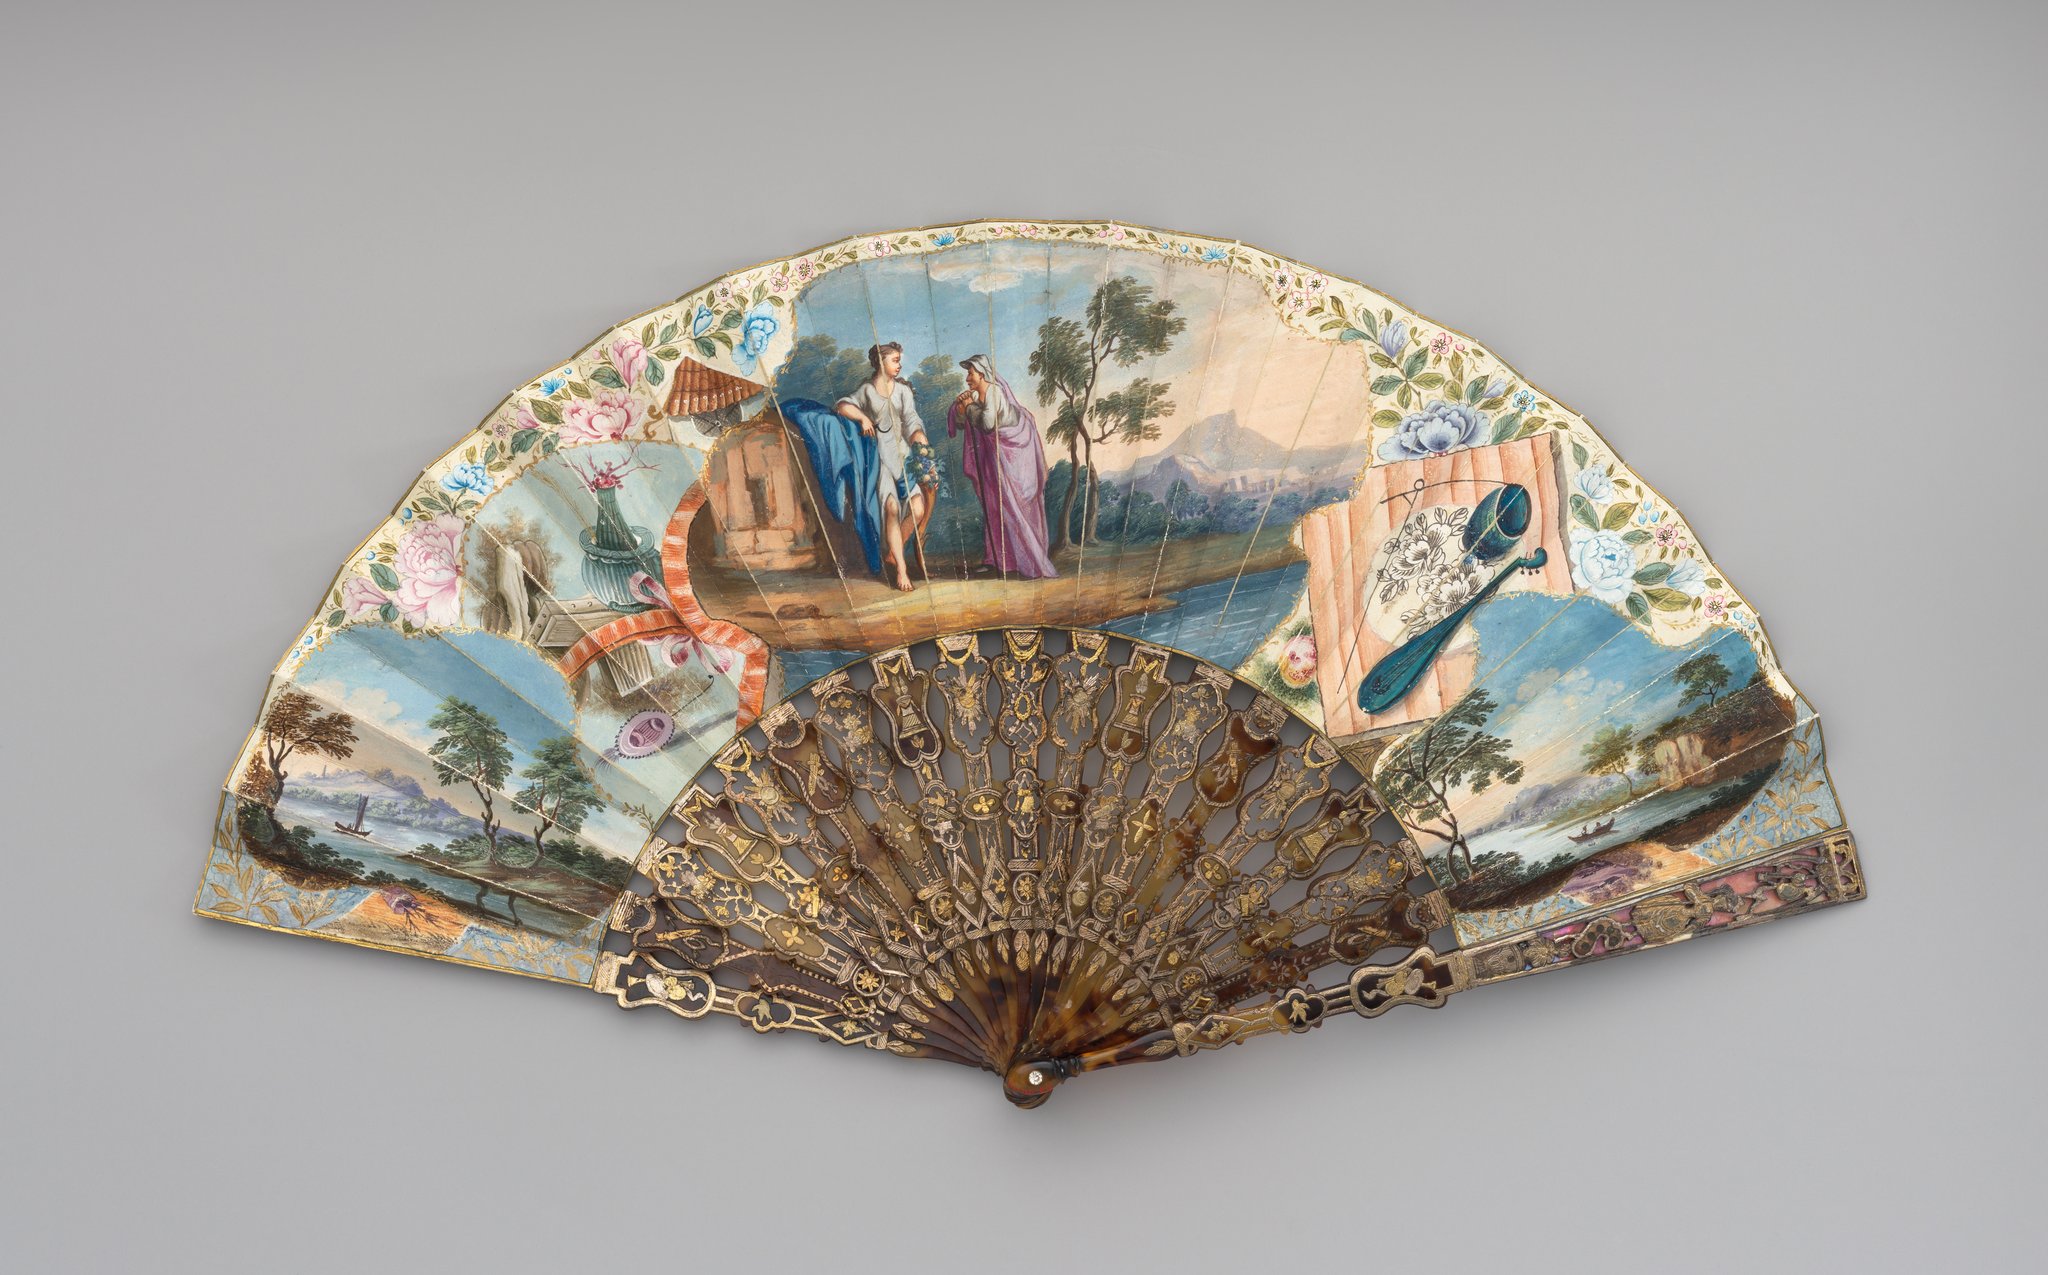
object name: fan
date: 1701-1800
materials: paper, shell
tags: men,women